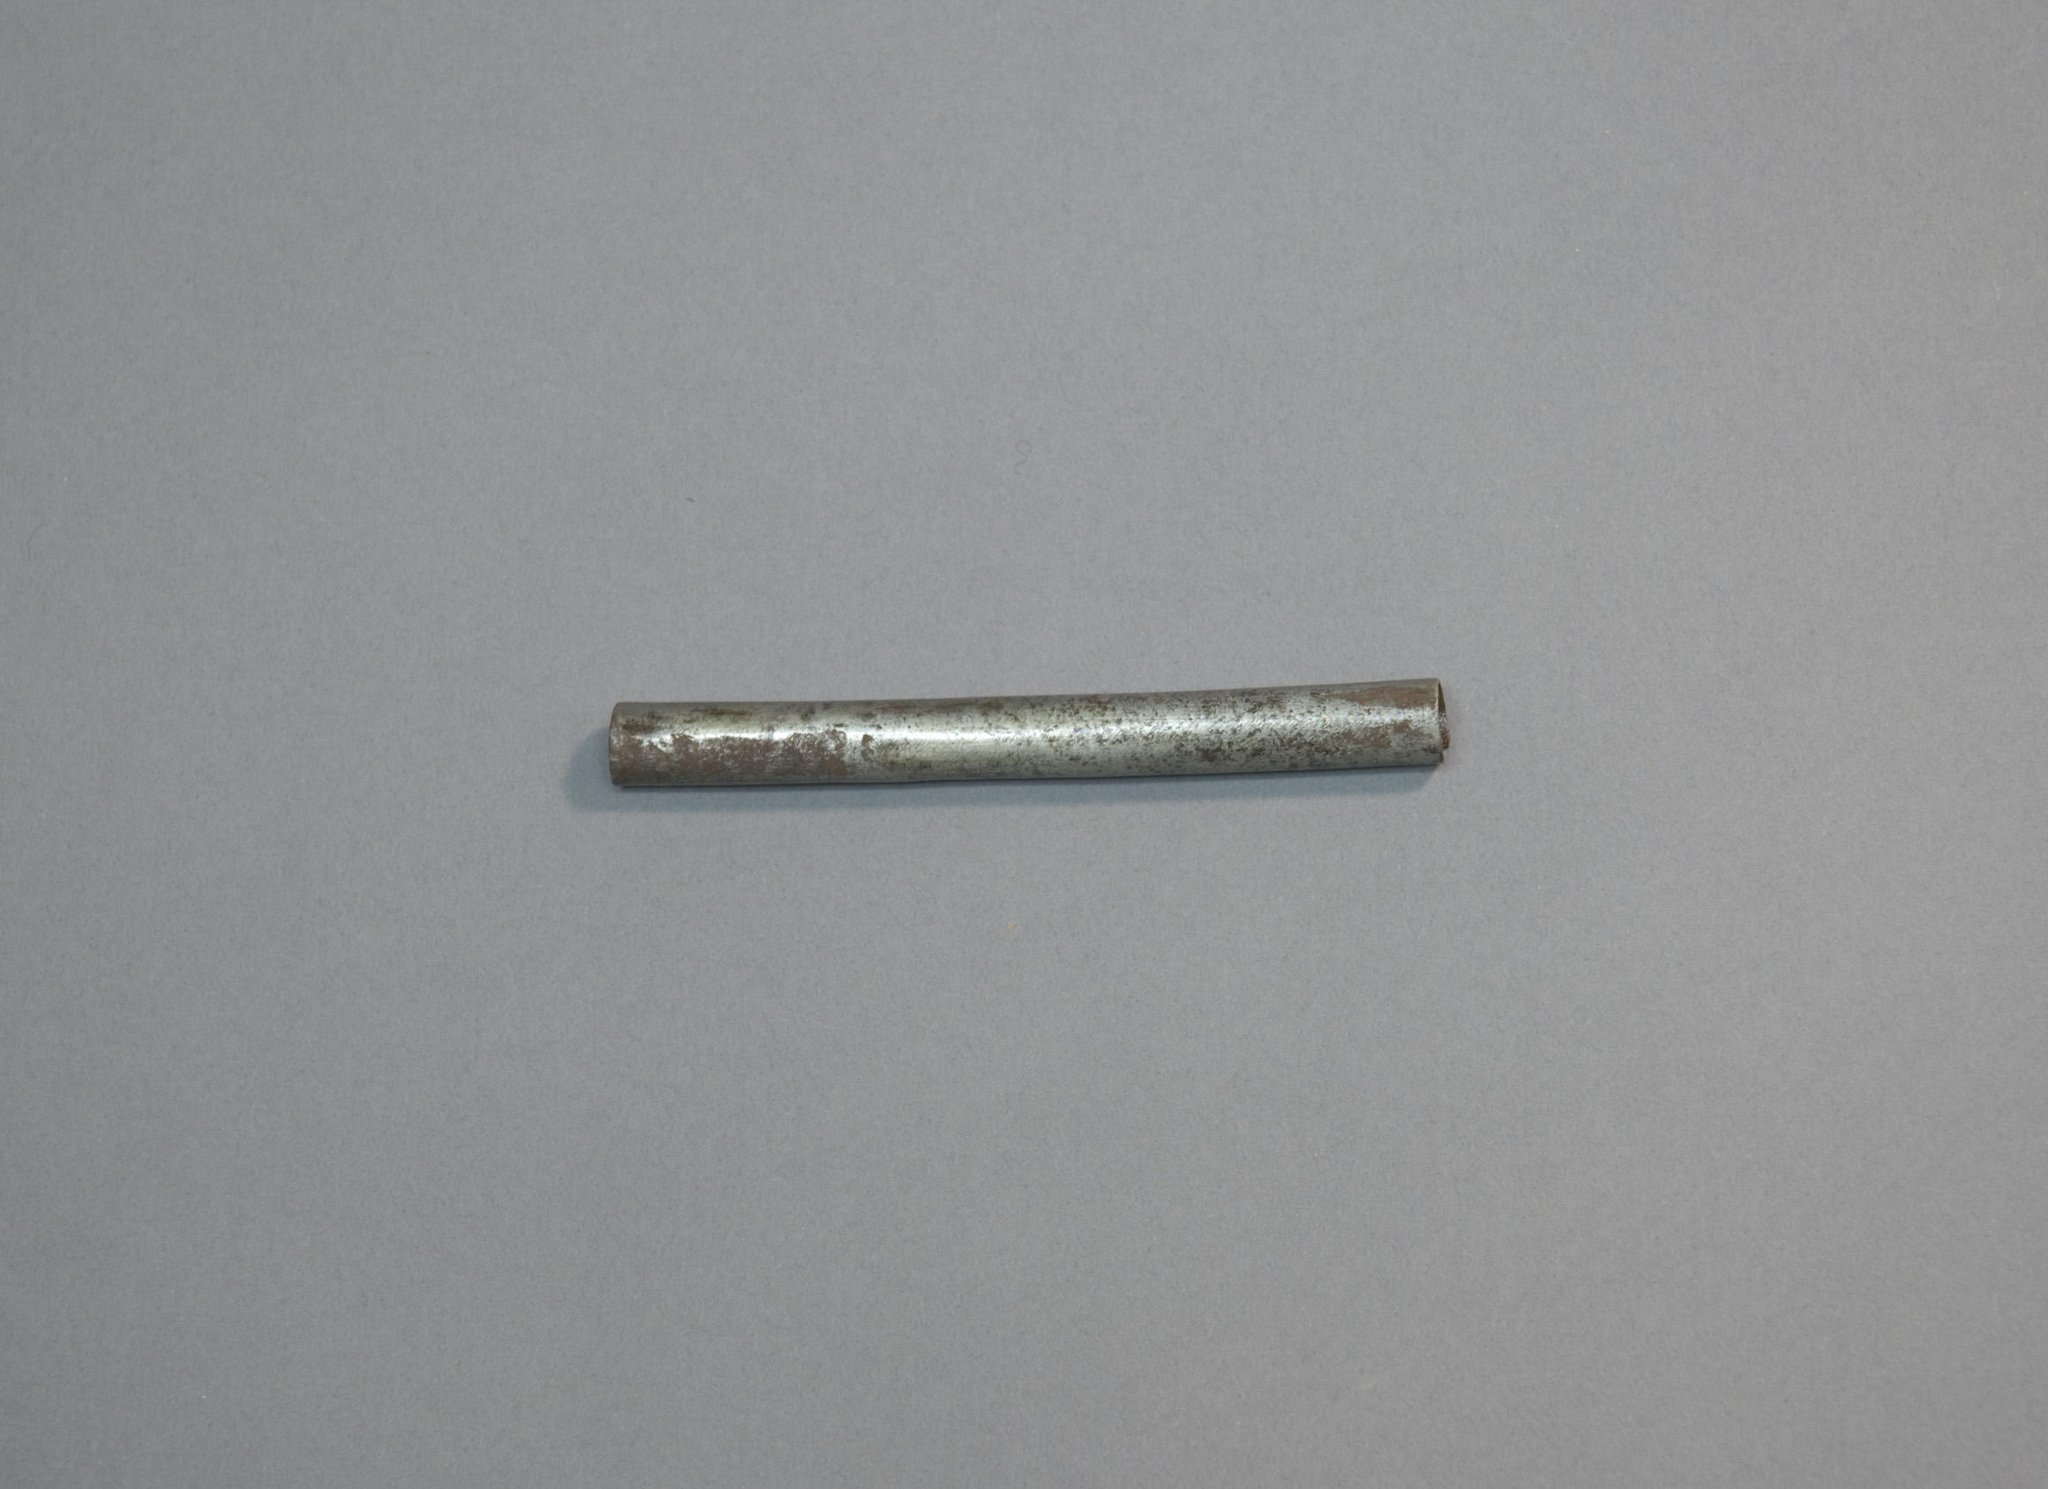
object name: jade carving tool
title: Tubular drill for carving jade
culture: chinese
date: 1901-2000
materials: steel